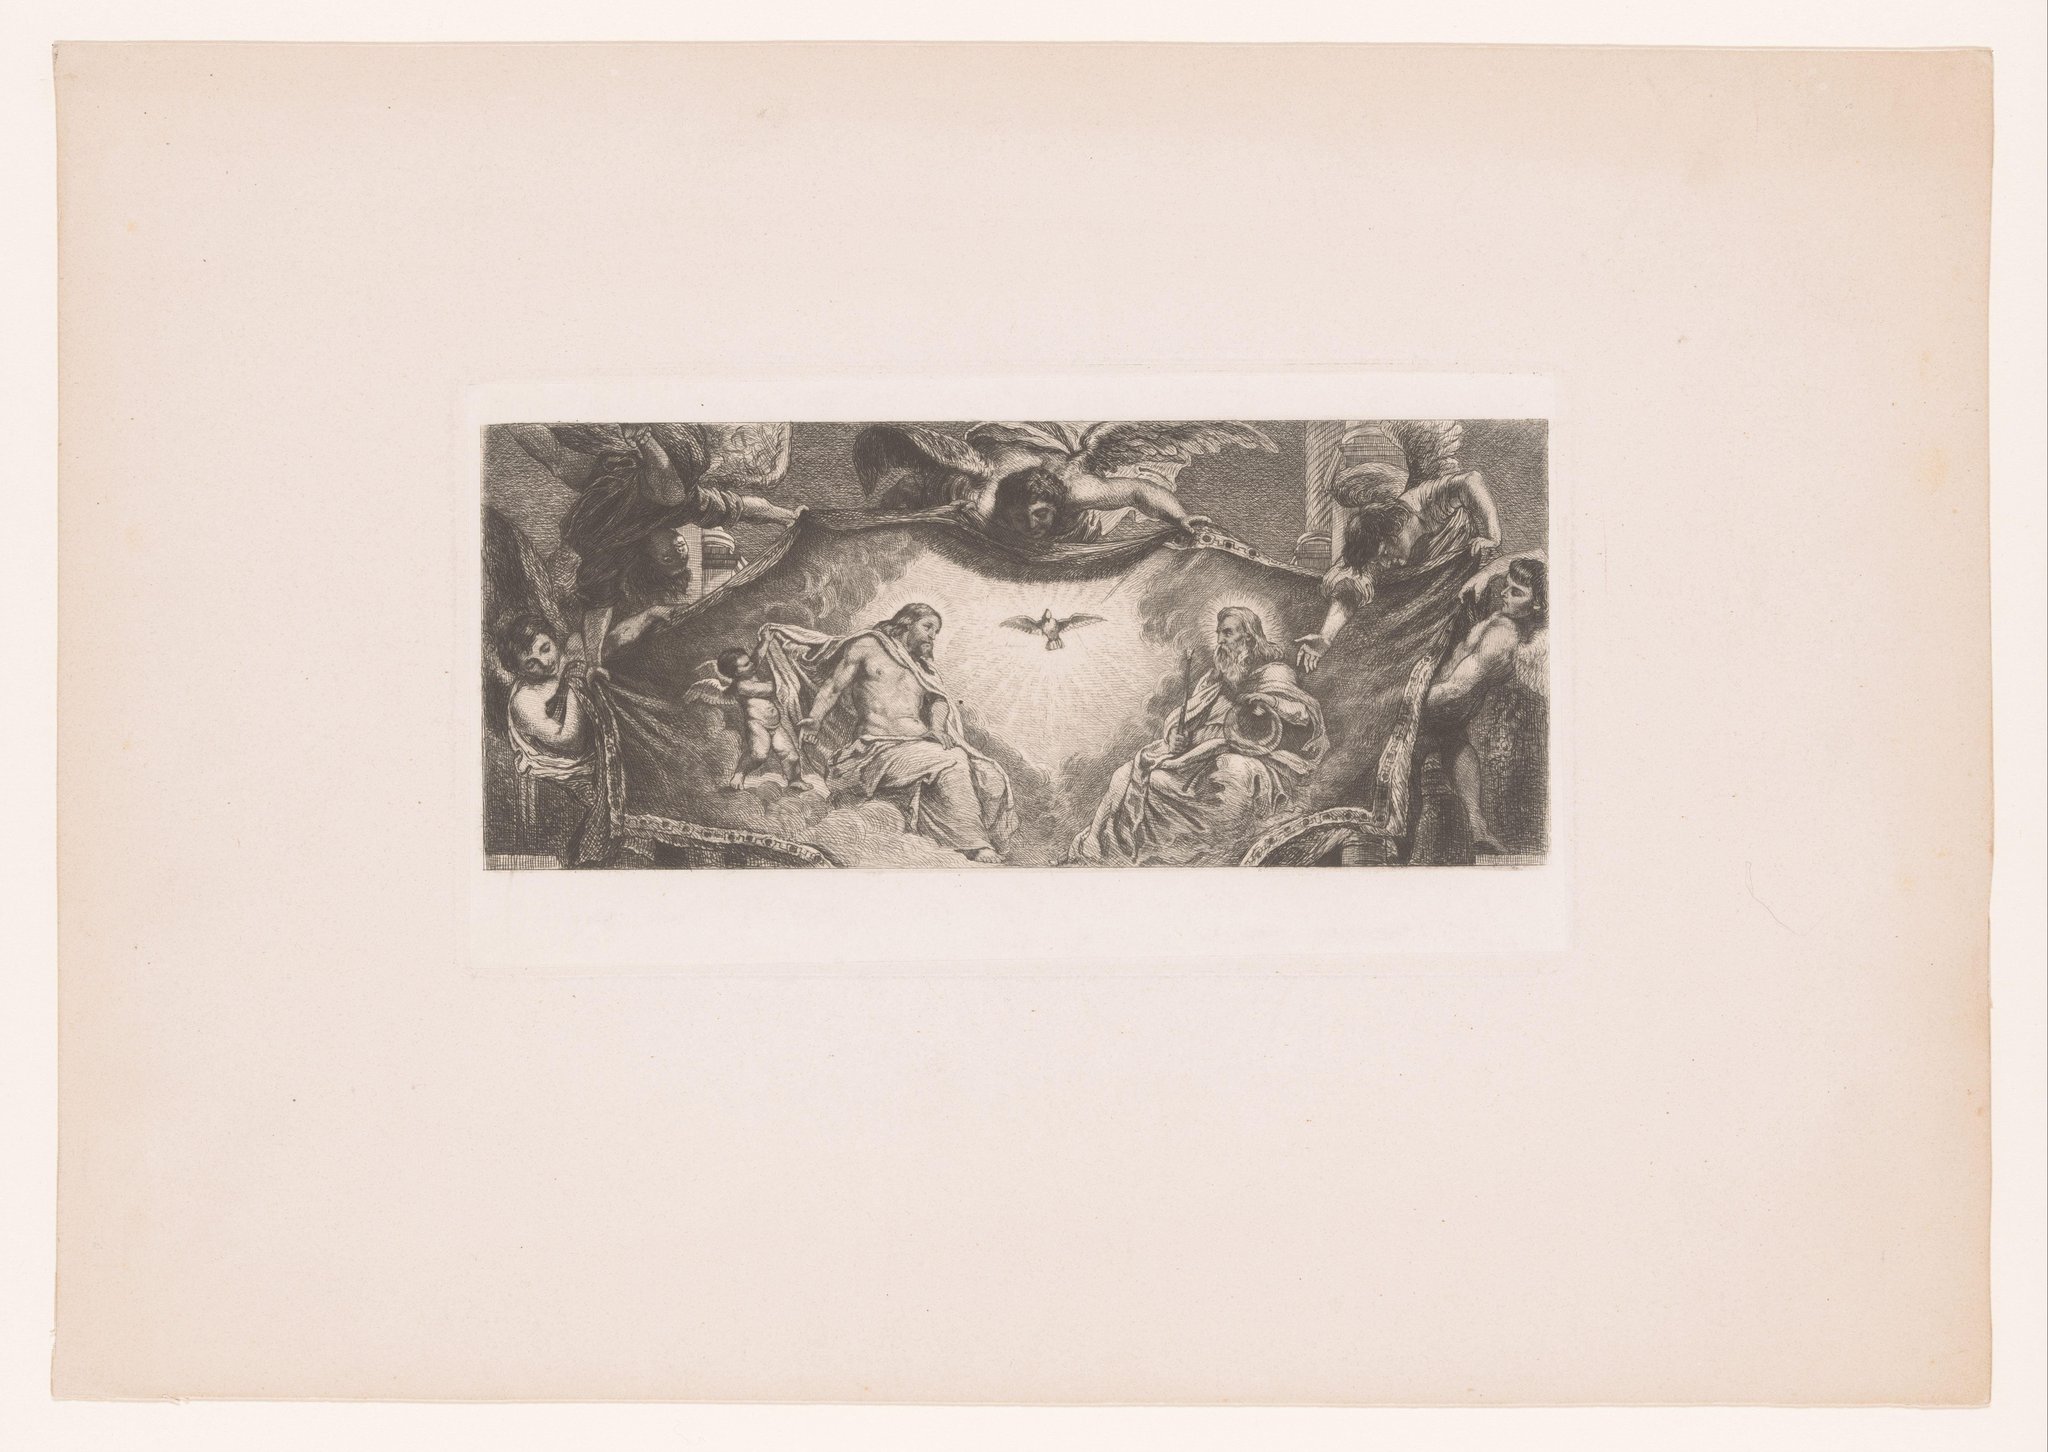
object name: print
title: Vader, Zoon en Heilige Geest op doek opgehouden door engelen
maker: Anonymous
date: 1750-1849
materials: paper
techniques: etching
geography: germany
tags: trinity in which god the father and christ are represented as persons, the holy ghost as dove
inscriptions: collector's mark: Lugt 2228